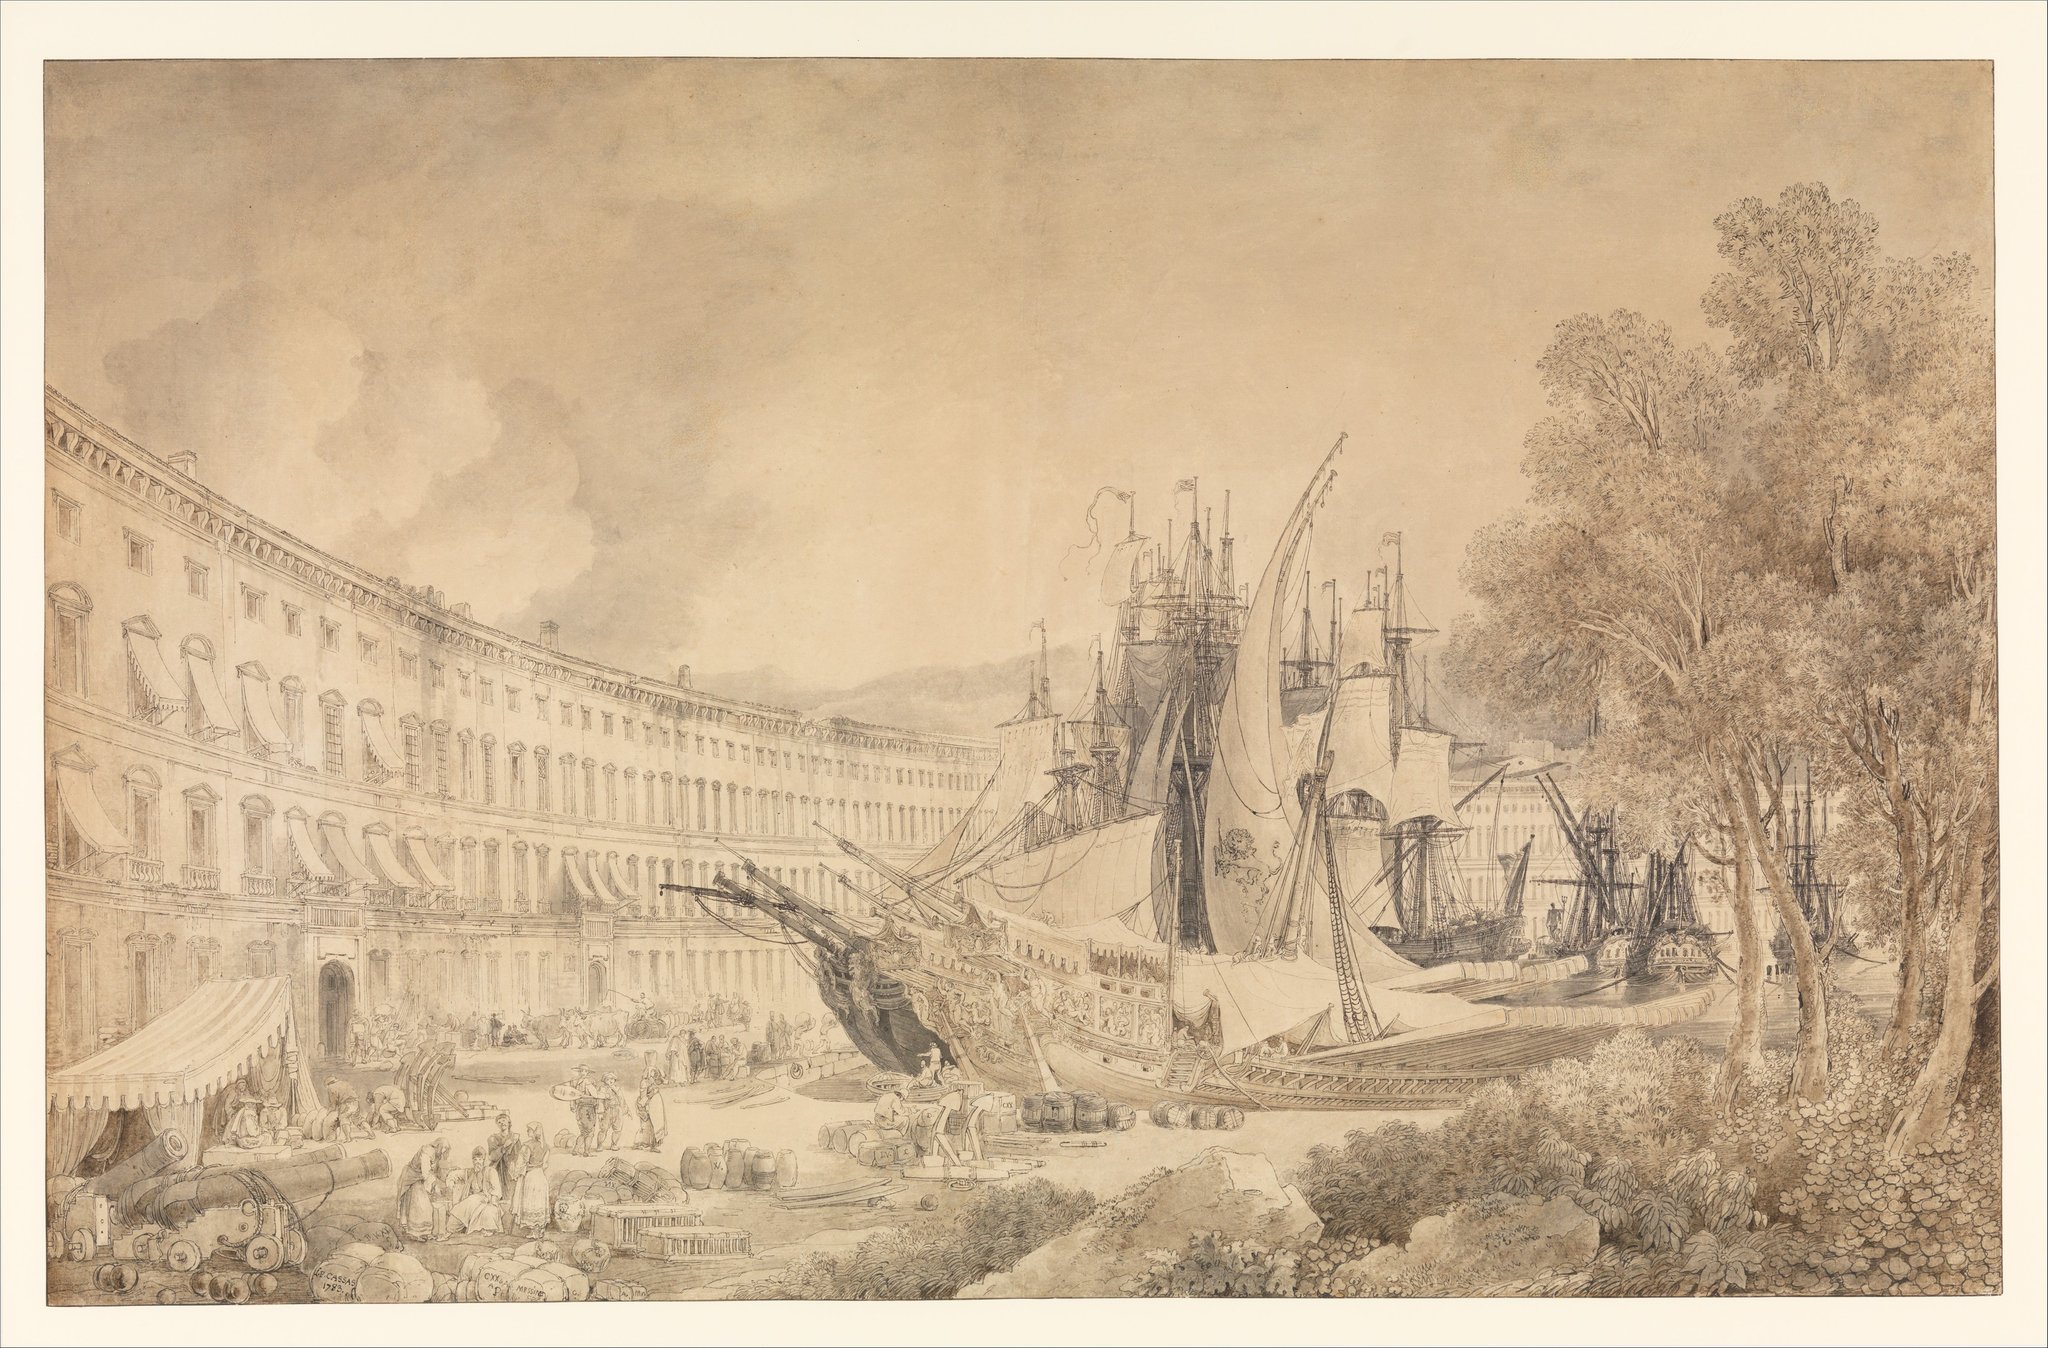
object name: drawing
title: View of Messina Harbor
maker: louis françois cassas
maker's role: artist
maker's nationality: french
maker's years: 1756-1827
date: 1783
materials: chalk, ink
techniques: brush, pen, wash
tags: buildings,ships